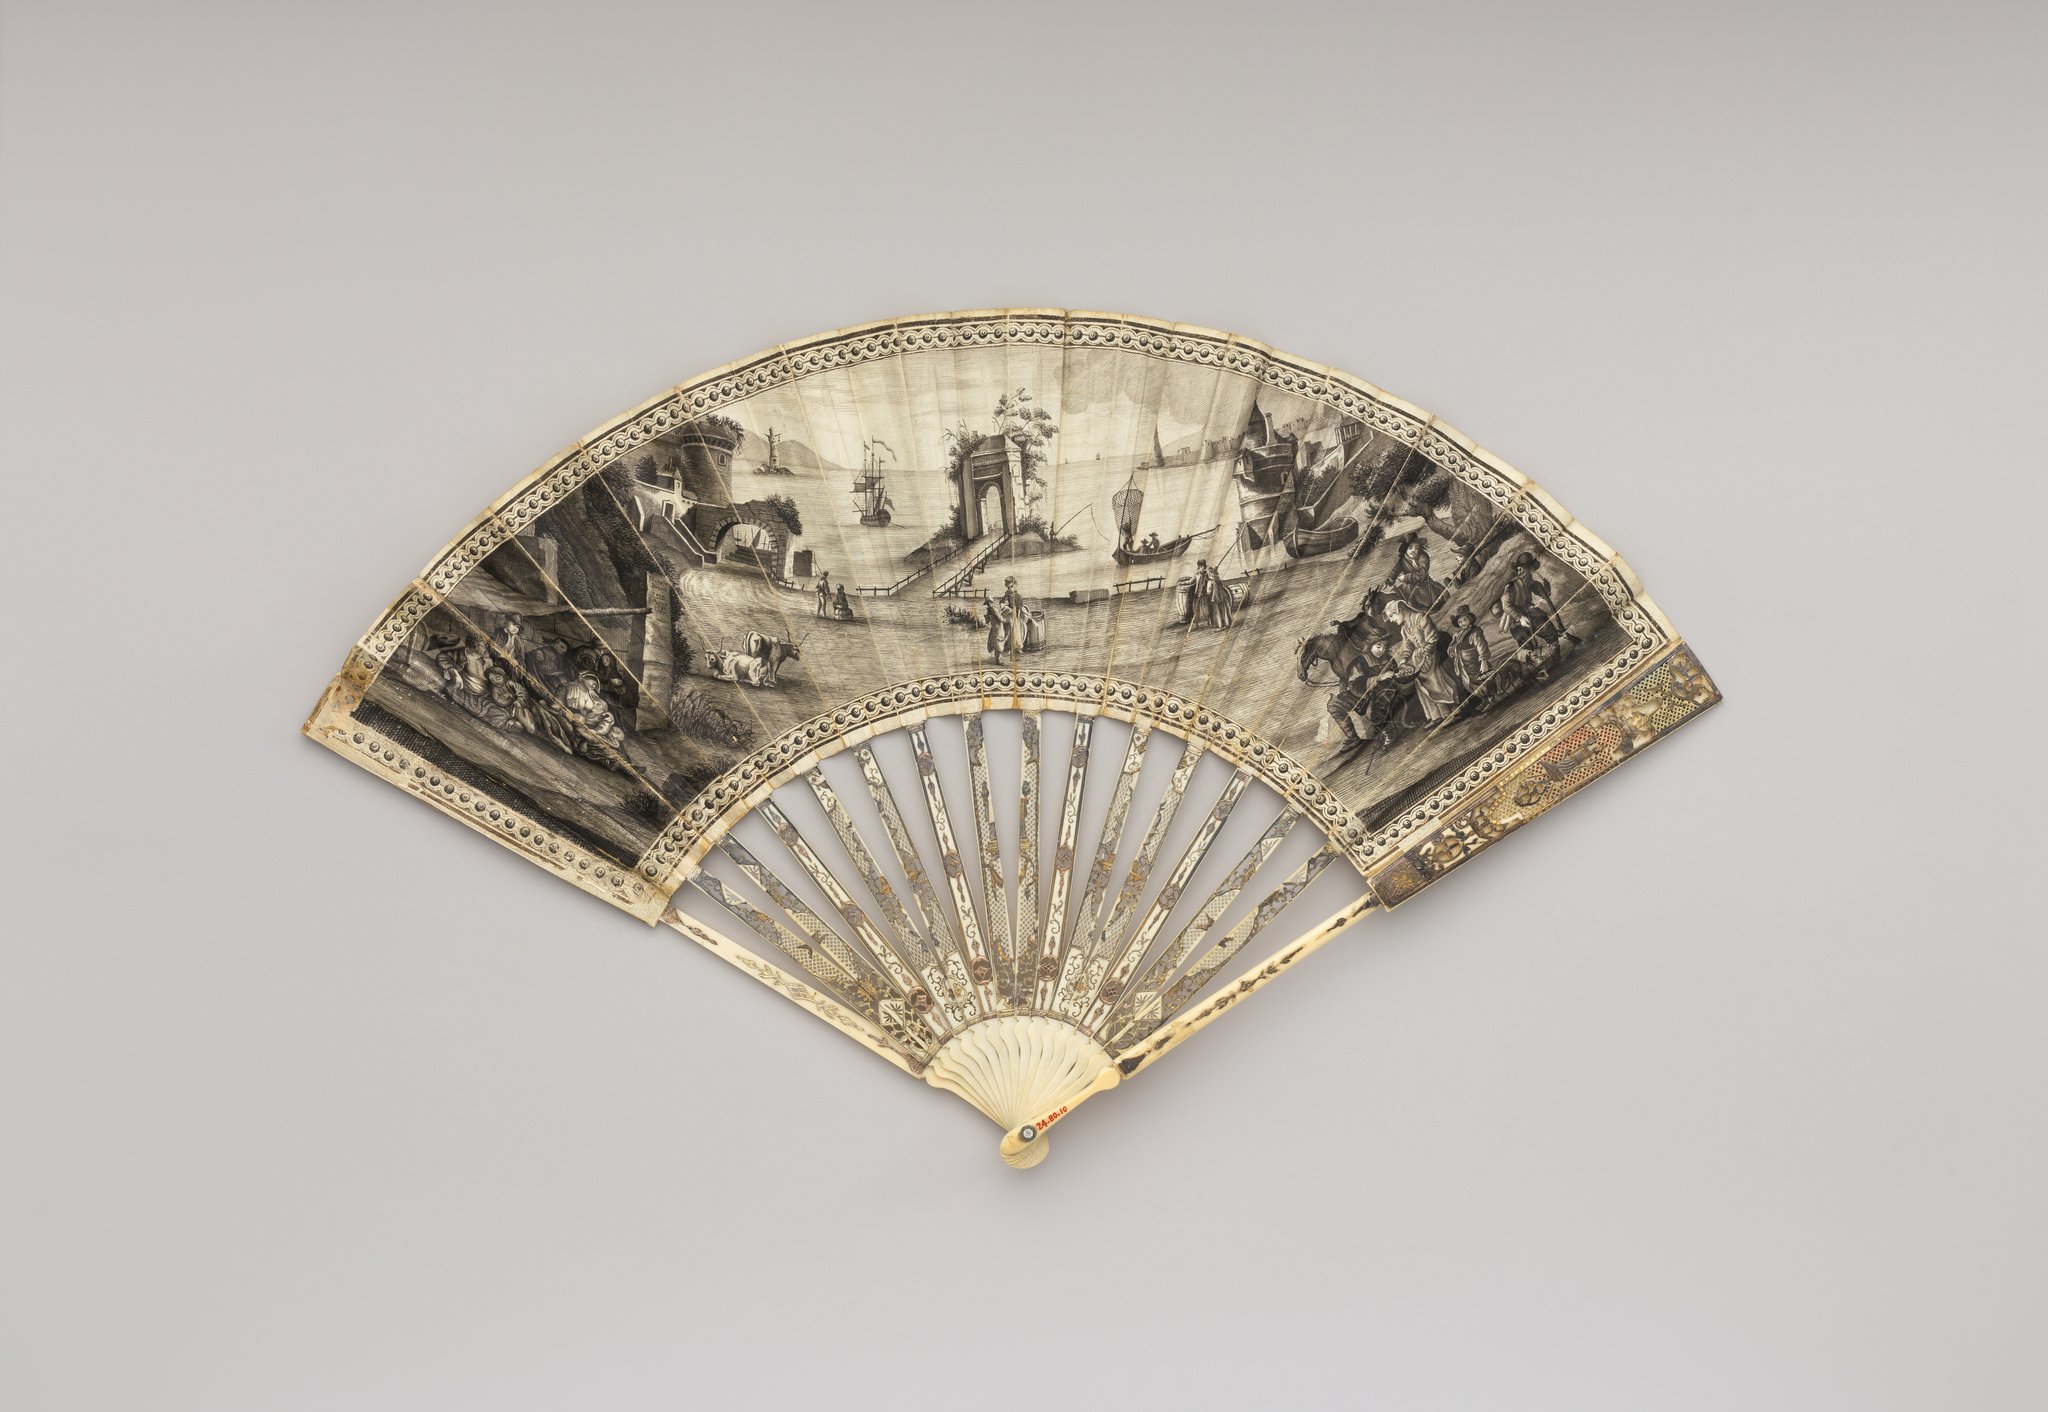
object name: fan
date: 1791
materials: ivory, skin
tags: men,music,horses,boats